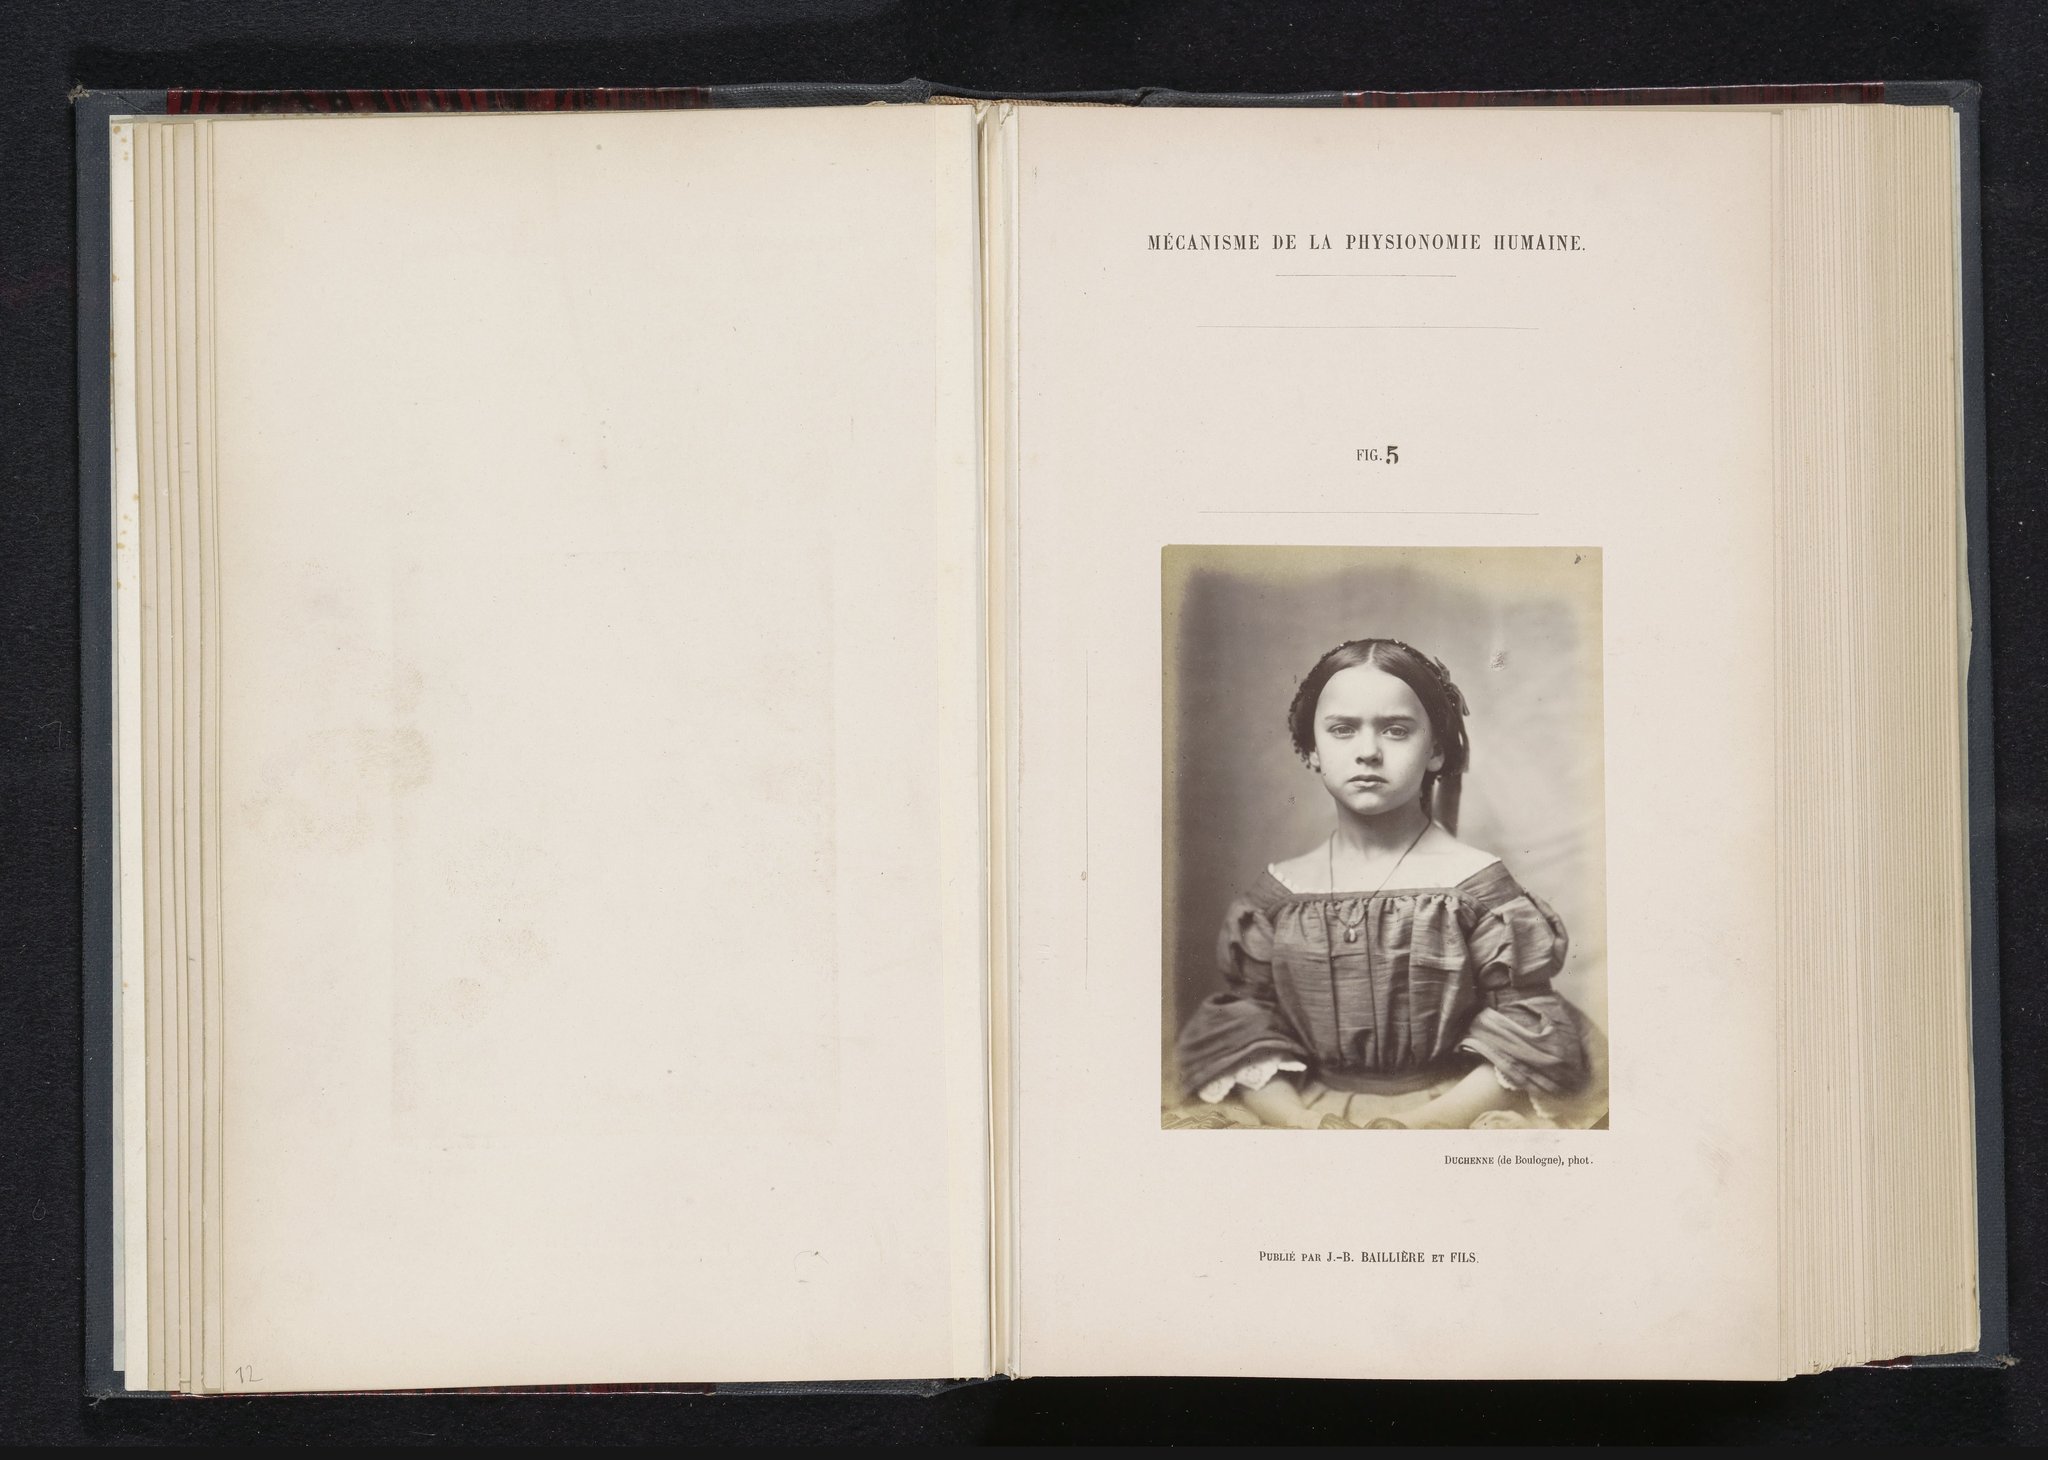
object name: photograph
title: Portret van een proefpersoon: 'une petite fille'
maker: guillaume benjamin amand duchenne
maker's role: fotograaf, medicus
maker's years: 1806-1875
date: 1860-1862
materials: paper, photographic support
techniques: albumen print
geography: paris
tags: face, physiology and anatomy ~ nervous system, neurology, child, physiology and anatomy, morphology of facial expression, physiognomy, experiment, test ~ science and technology, france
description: Ongenummerde pagina met foto 5 uit Mécanisme de la physionomie humaine ou analyse électro-physiologique de l'expression des passions (Atlas).